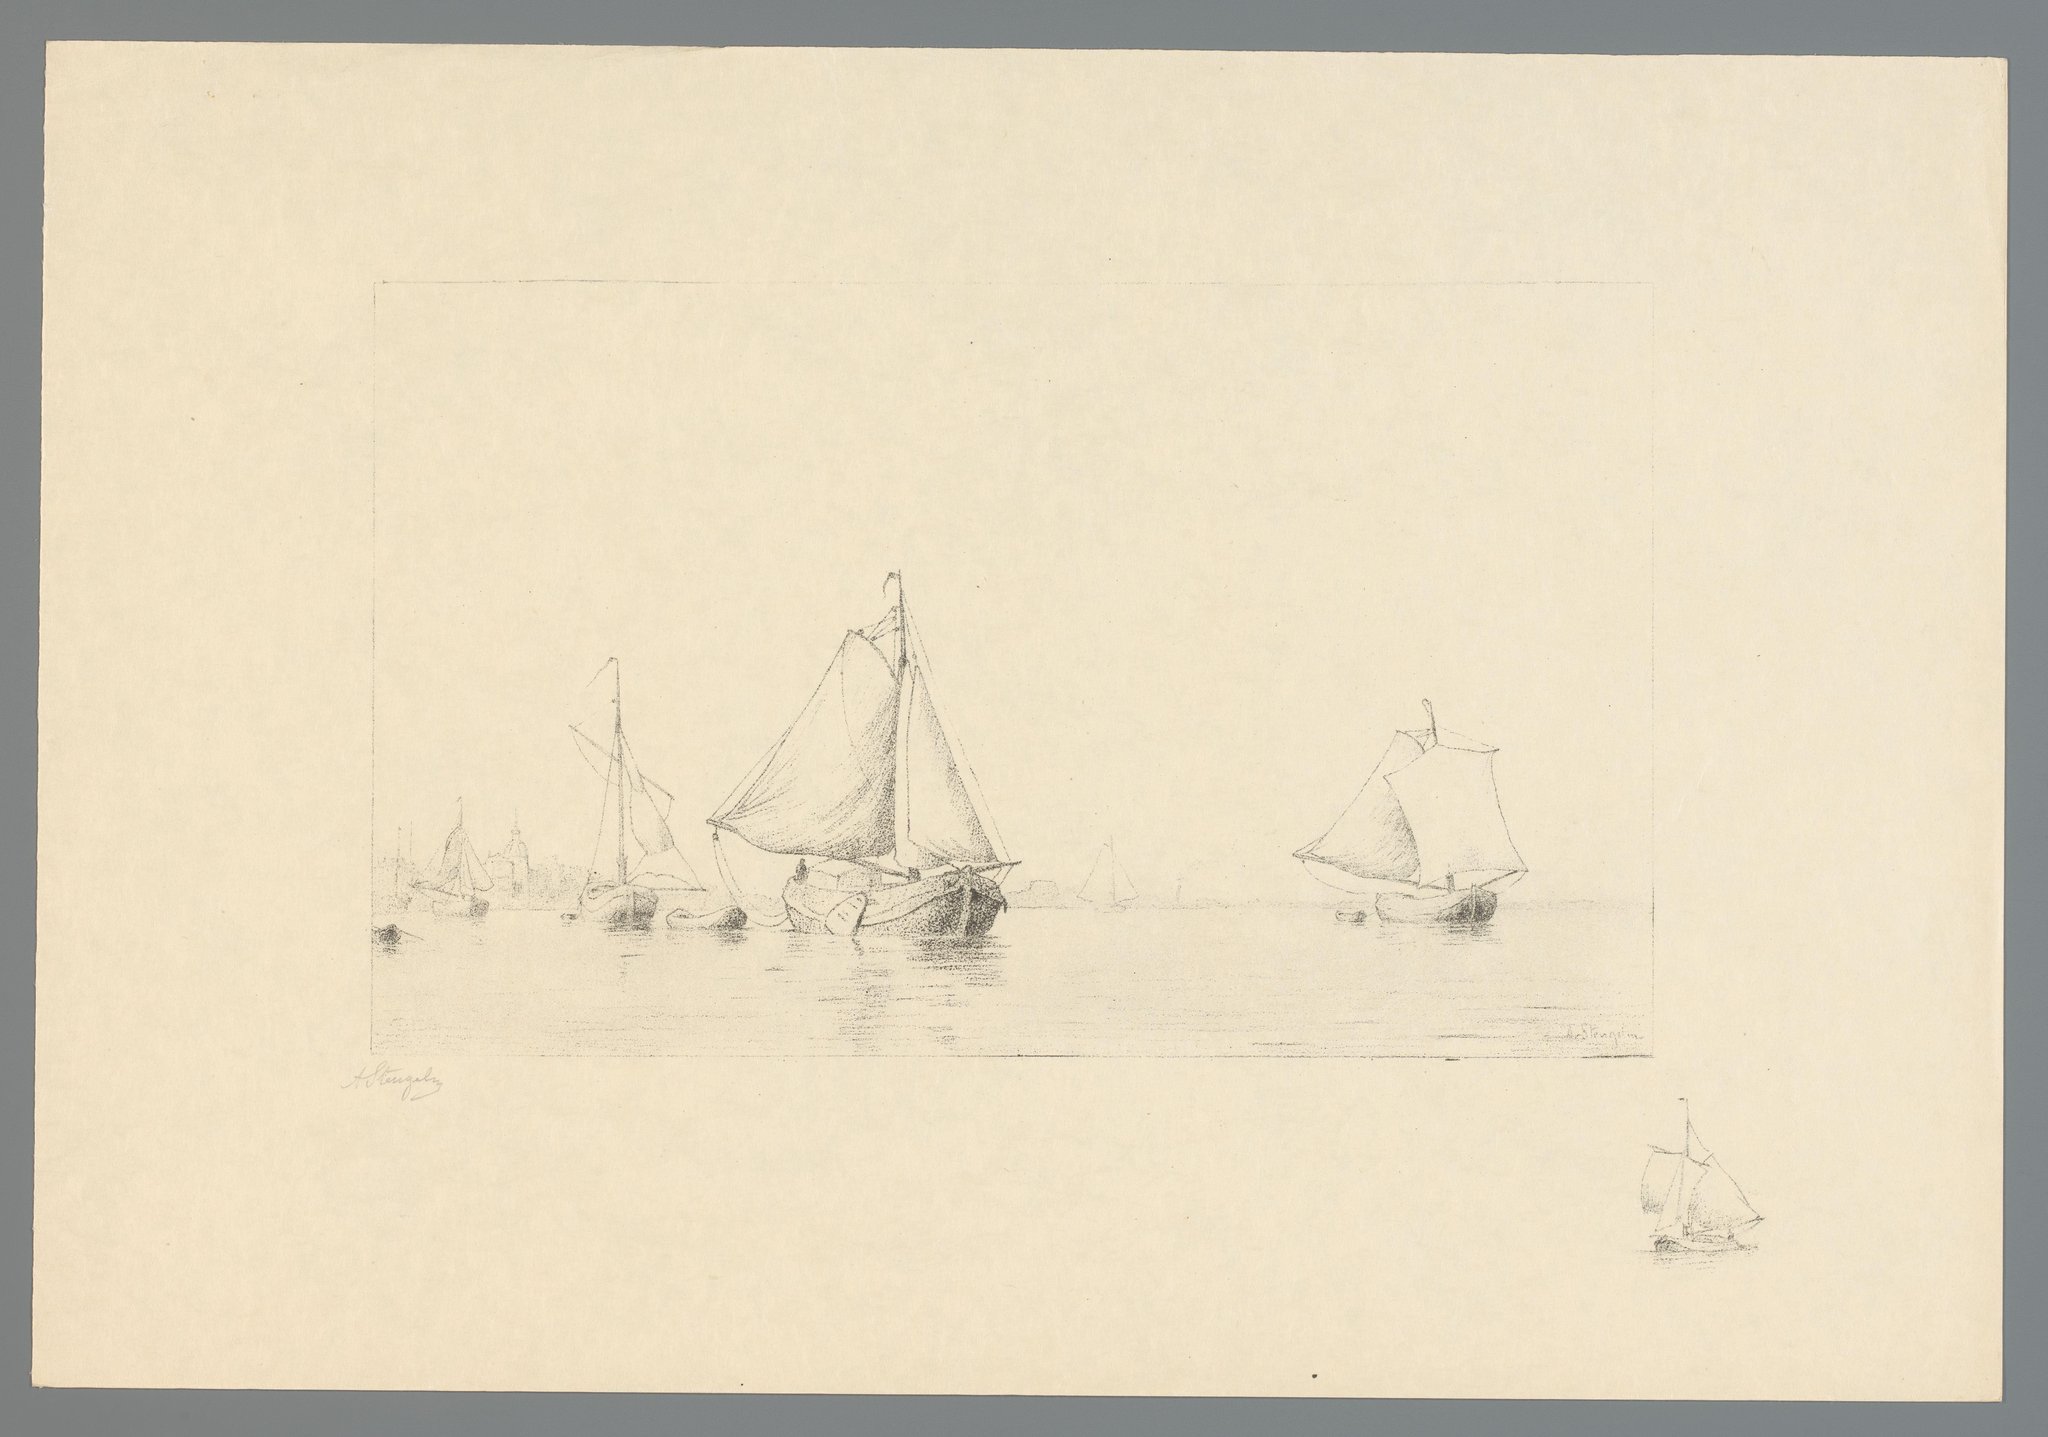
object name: print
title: Meuse près Dordrecht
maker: alphonse stengelin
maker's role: painter, print maker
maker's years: 1852-1938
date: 1876-1910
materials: paper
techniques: lithograph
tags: sailing-ship, sailing-boat, river, dordrecht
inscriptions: collector's mark: Lugt 2228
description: Rechtsonder een remarque met een zeilschip.